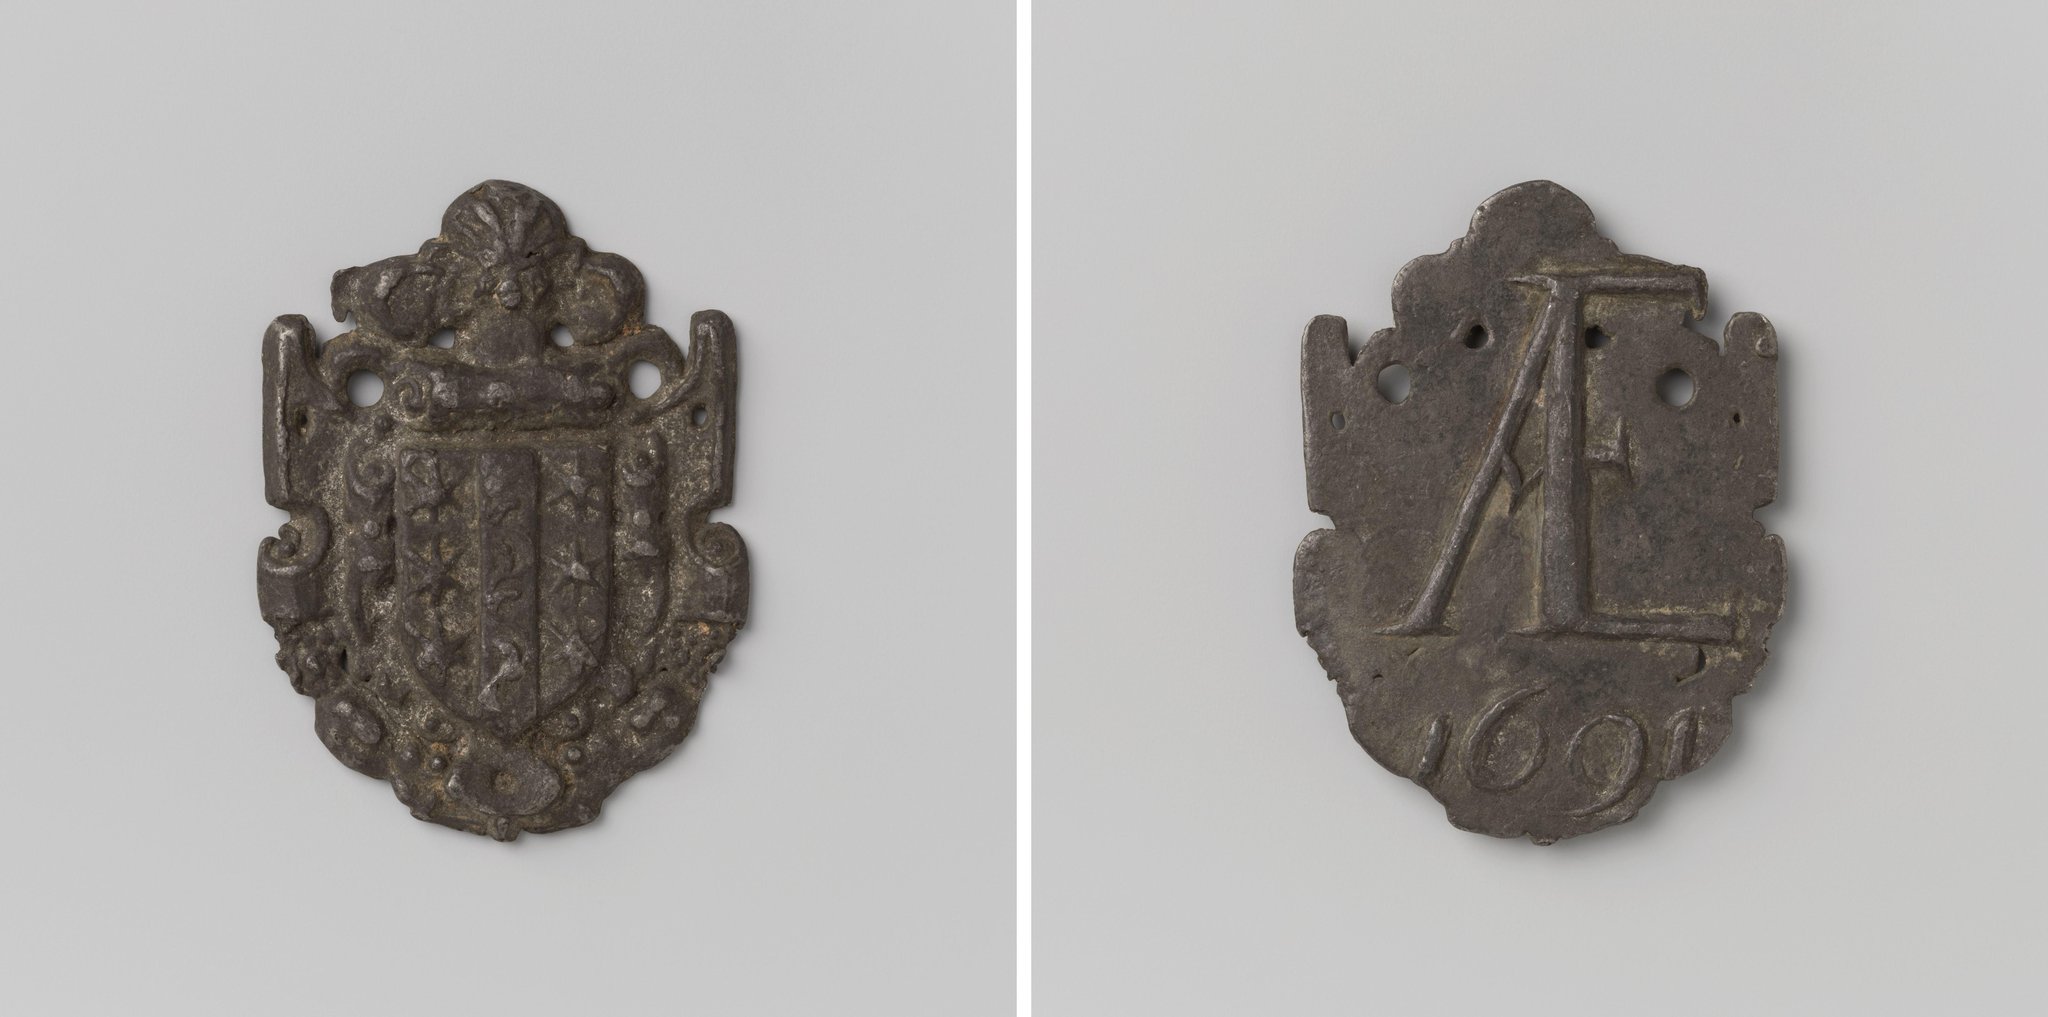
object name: tax token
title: Stad Gouda, loodje goed voor een ton turf en een gift in geld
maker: Anonymous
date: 1691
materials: lead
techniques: casting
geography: gouda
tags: gouda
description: penning van onregelmatige vorm. Voorzijde: wapenschild in sierlijk cartouche. Keerzijde: monogram van letters A en E boven jaartal